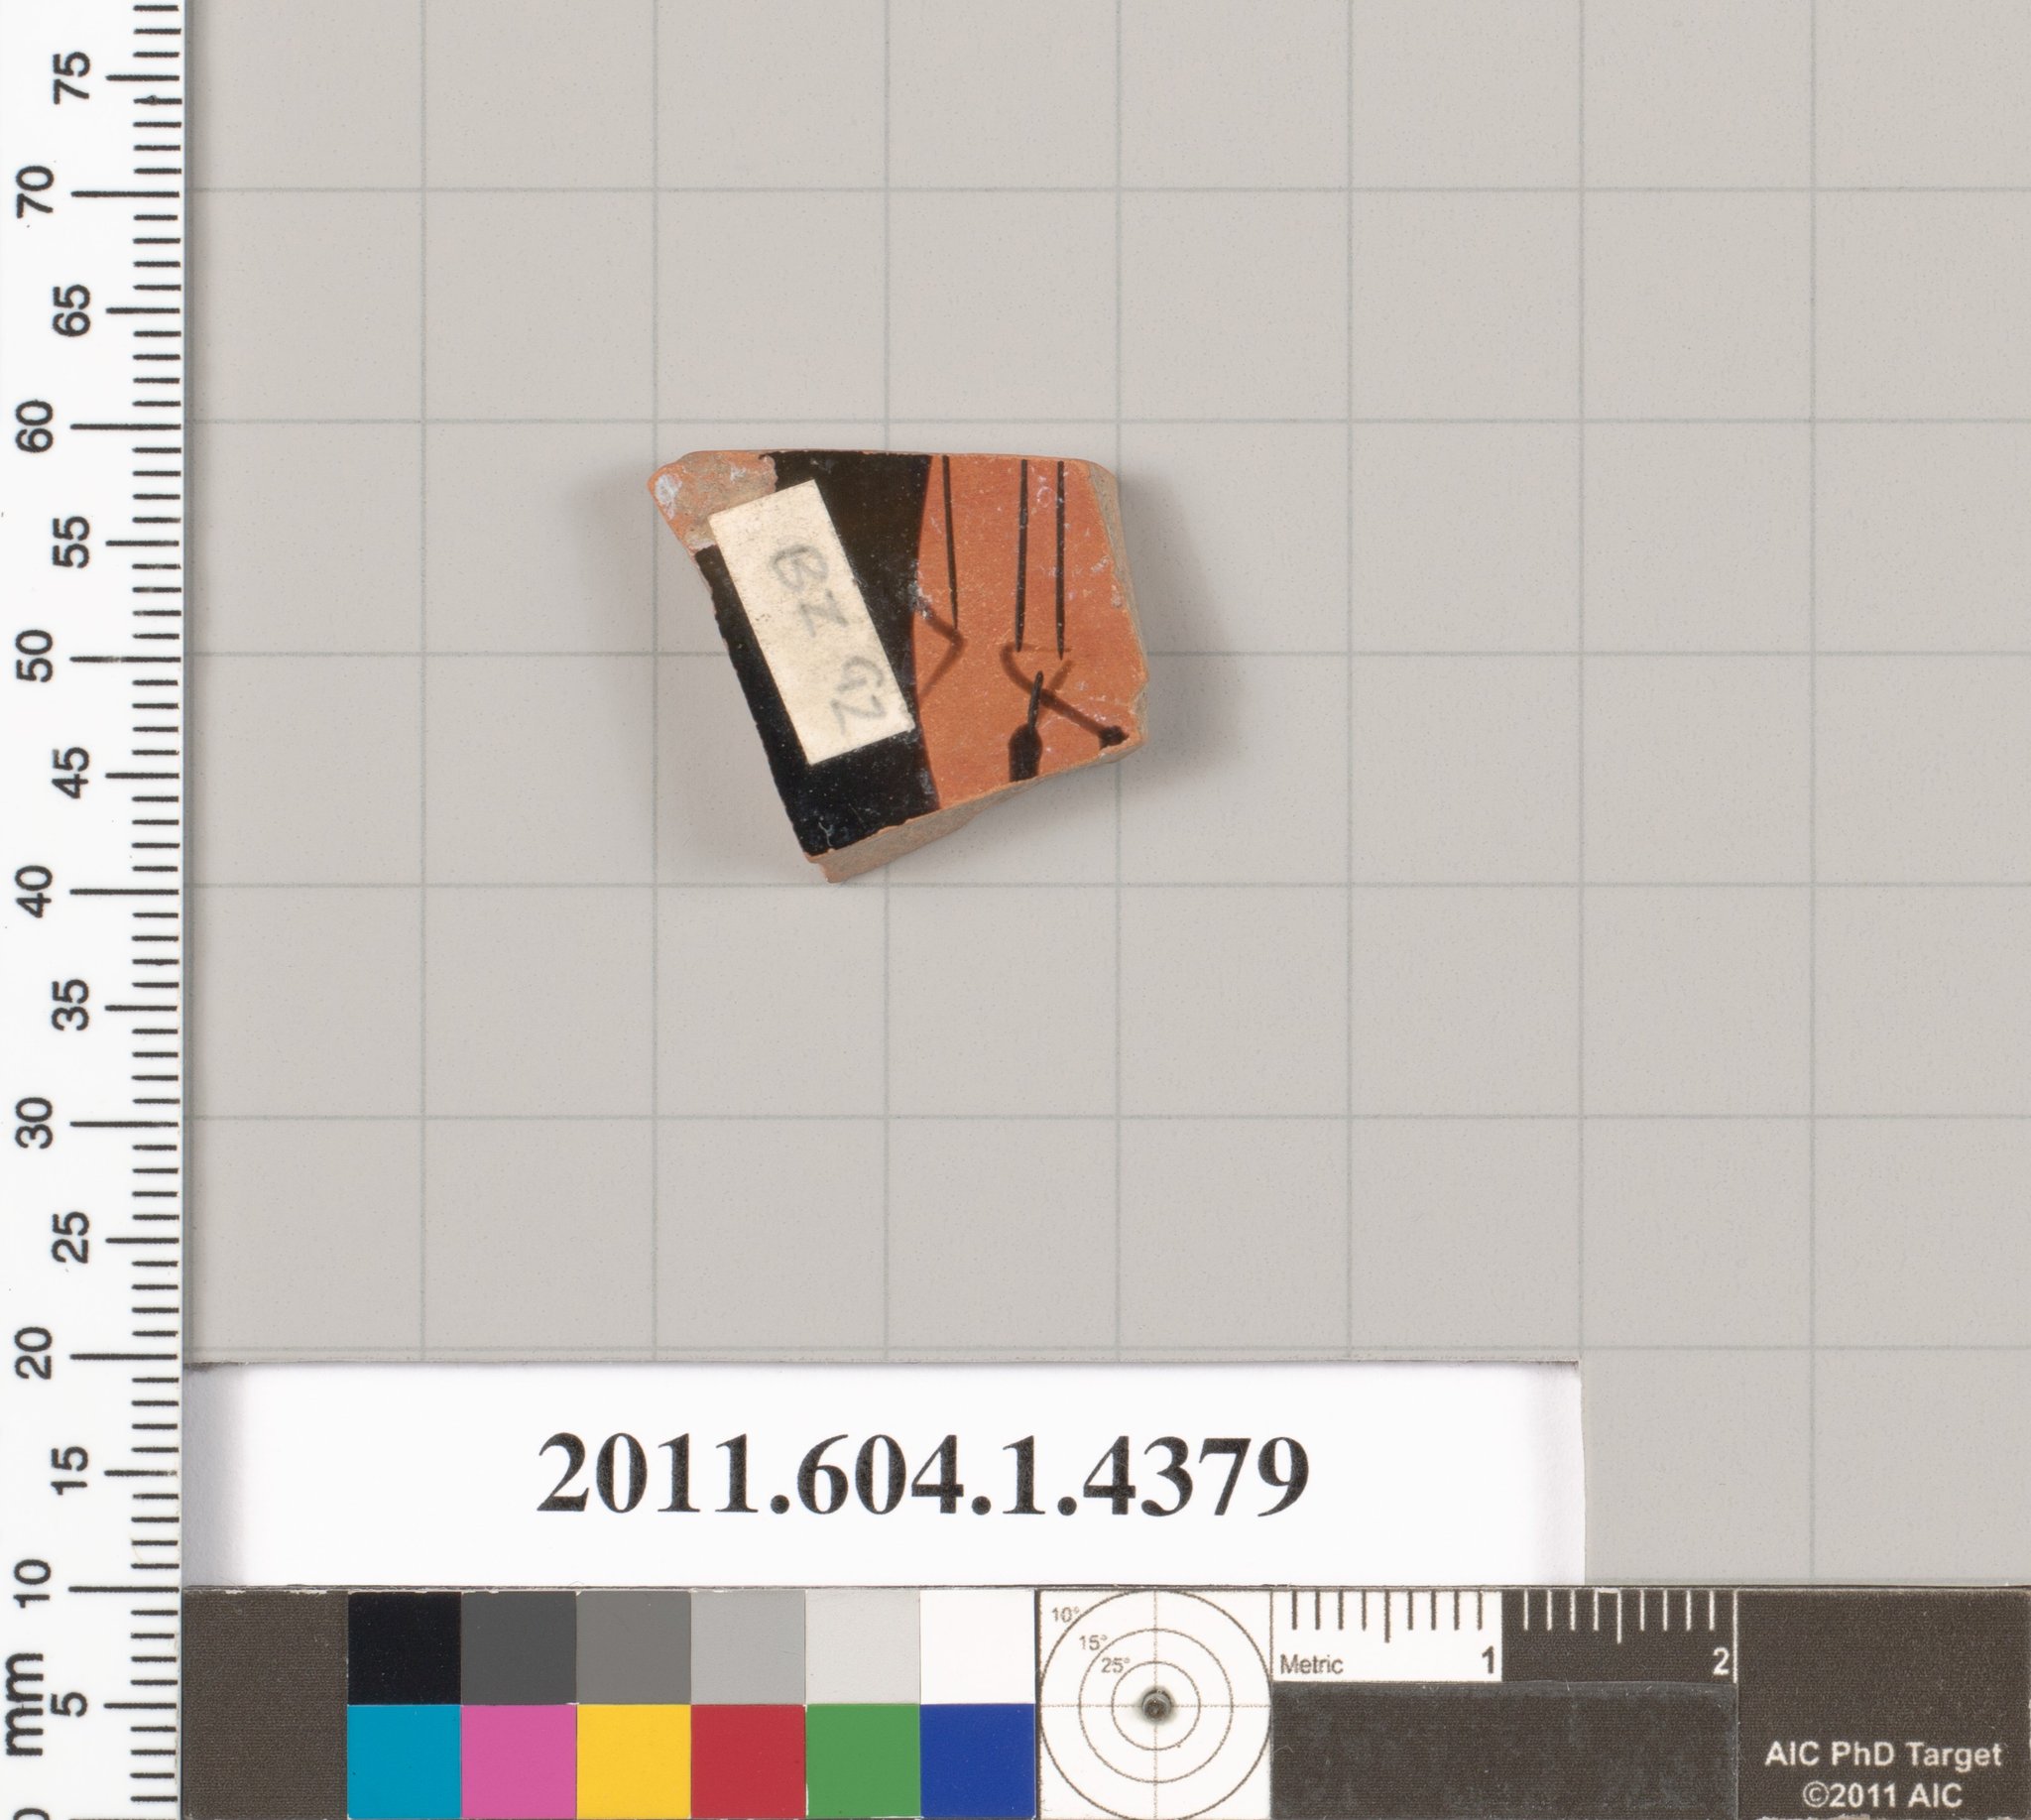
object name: kylix fragment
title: Terracotta fragment of a kylix (drinking cup)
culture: greek, attic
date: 475-451 BCE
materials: terracotta